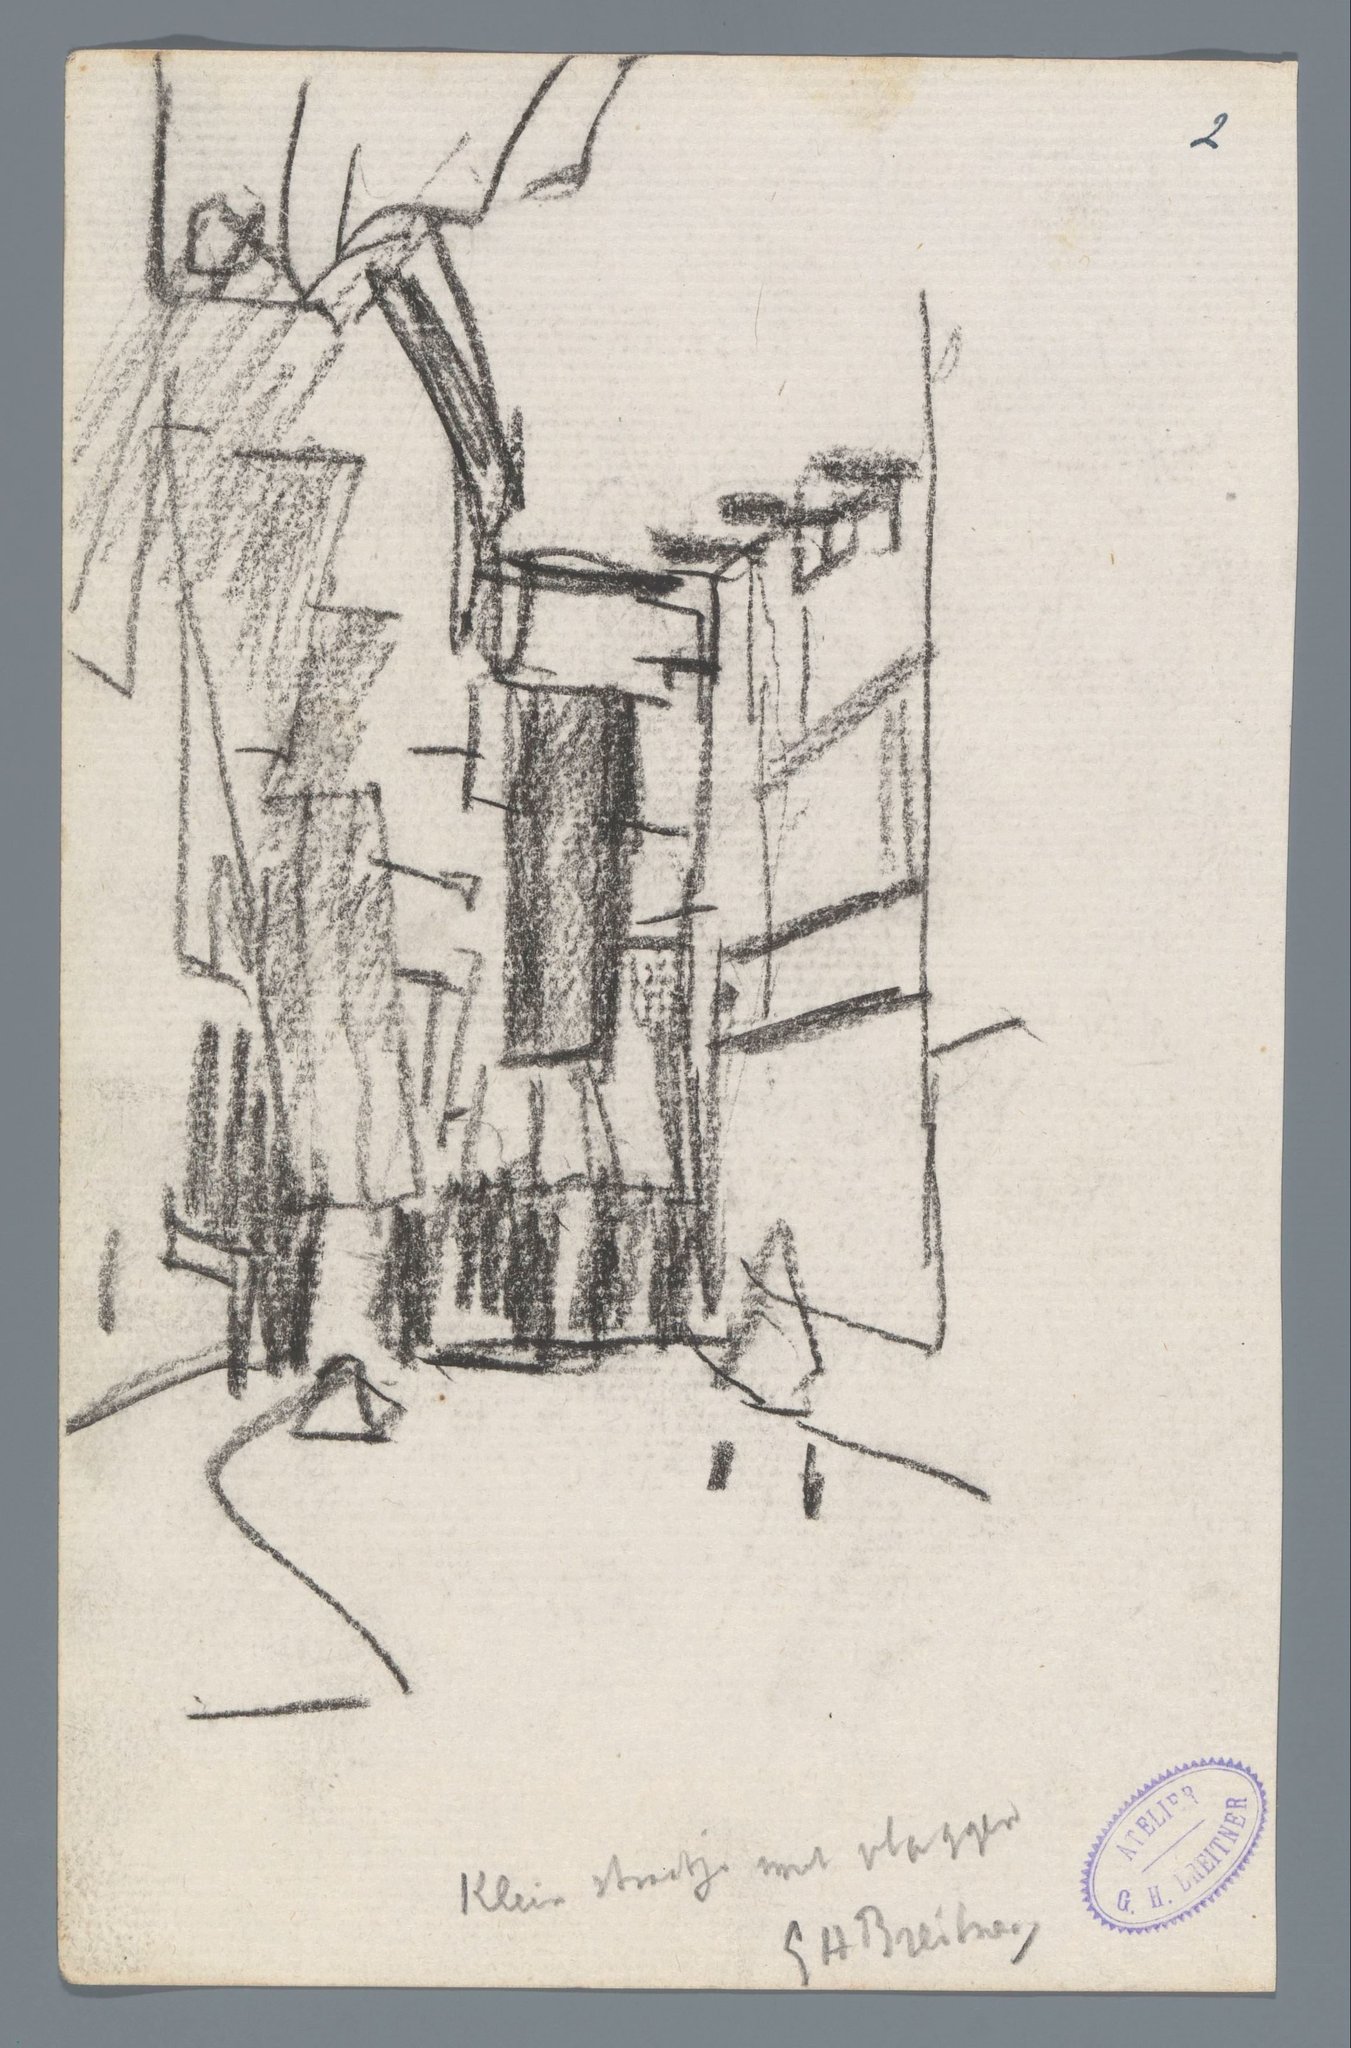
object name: drawing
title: Gezicht op een smalle straat met vlaggen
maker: george hendrik breitner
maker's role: draughtsman, painter, print maker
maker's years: 1857-1923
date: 1886-1923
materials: chalk, paper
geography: amsterdam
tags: flag, colours (as symbol of the state, etc.) (+ city; municipal), street (+ city(-scape) with figures, staffage)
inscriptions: signature: ‘G H Breitner’, workshop stamp: Lugt 291d, annotation: ‘Klein straatje met vlaggen’